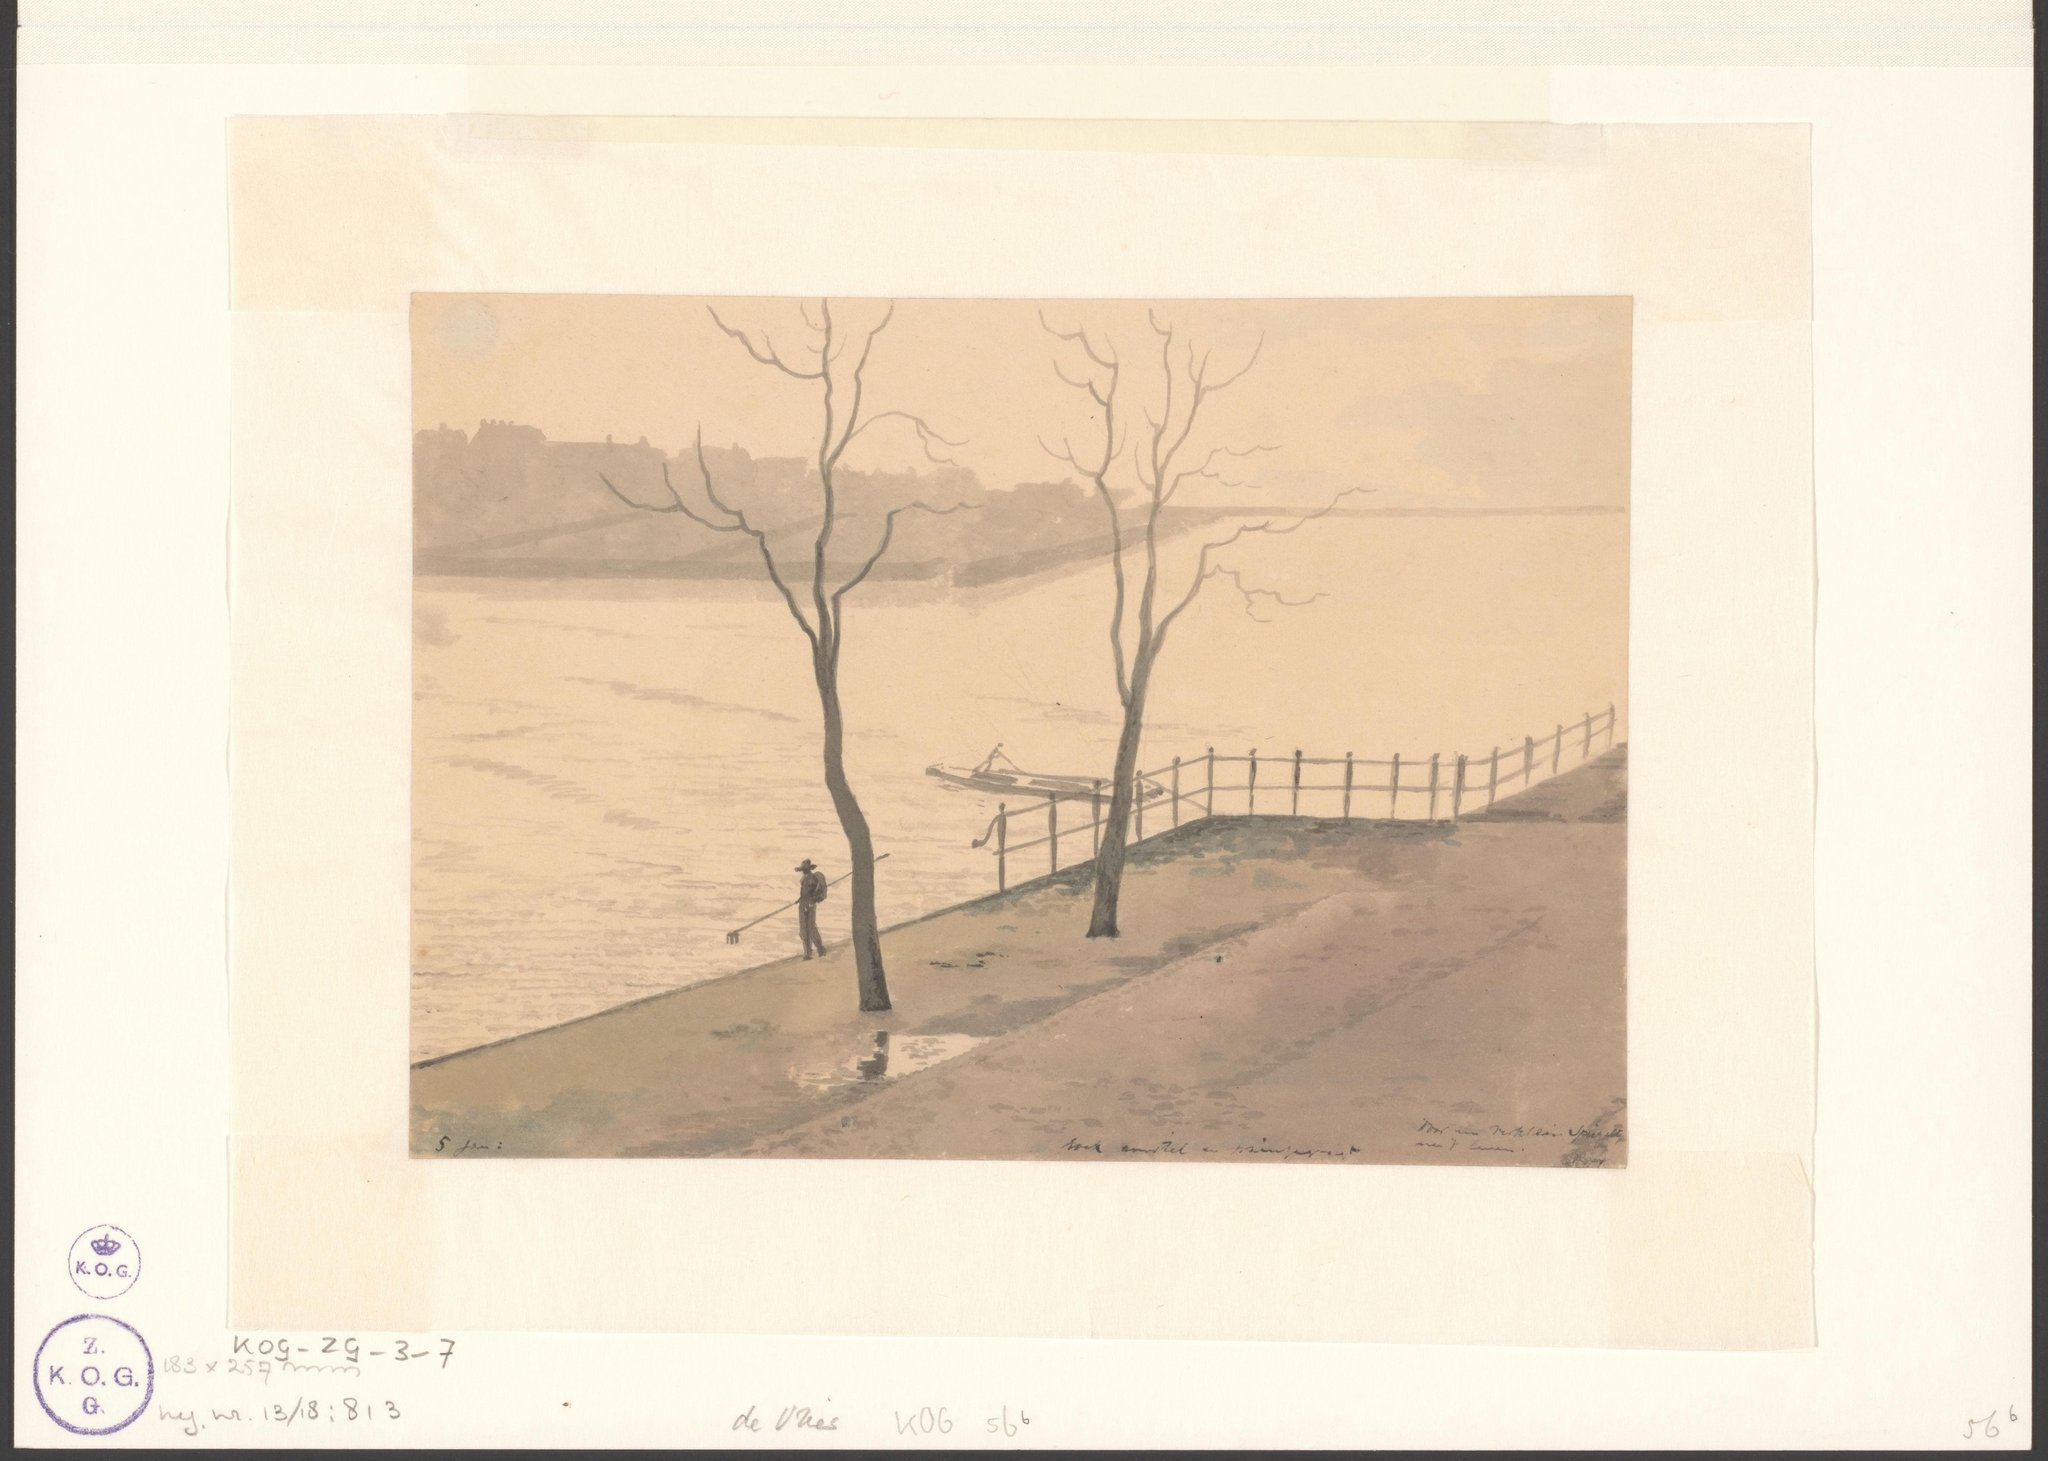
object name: drawing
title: Gezicht op de hoek van de Amstel en de Prinsengracht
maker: christiaan andriessen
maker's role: draughtsman, print maker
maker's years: 1775-1846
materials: ink, paper, pencil, watercolor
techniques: brush, pen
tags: river, canal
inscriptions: collector's mark: Lugt 1641a, inscription:, inscription: ‘Hoek Amstel en Prinsengracht / door een verklein spiegeltje na 't leven’, collector's mark: Lugt 1641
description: Dagboekblad uit het getekende dagboek dat Christiaan Andriessen bijhield van 1805 tot en met 1808.